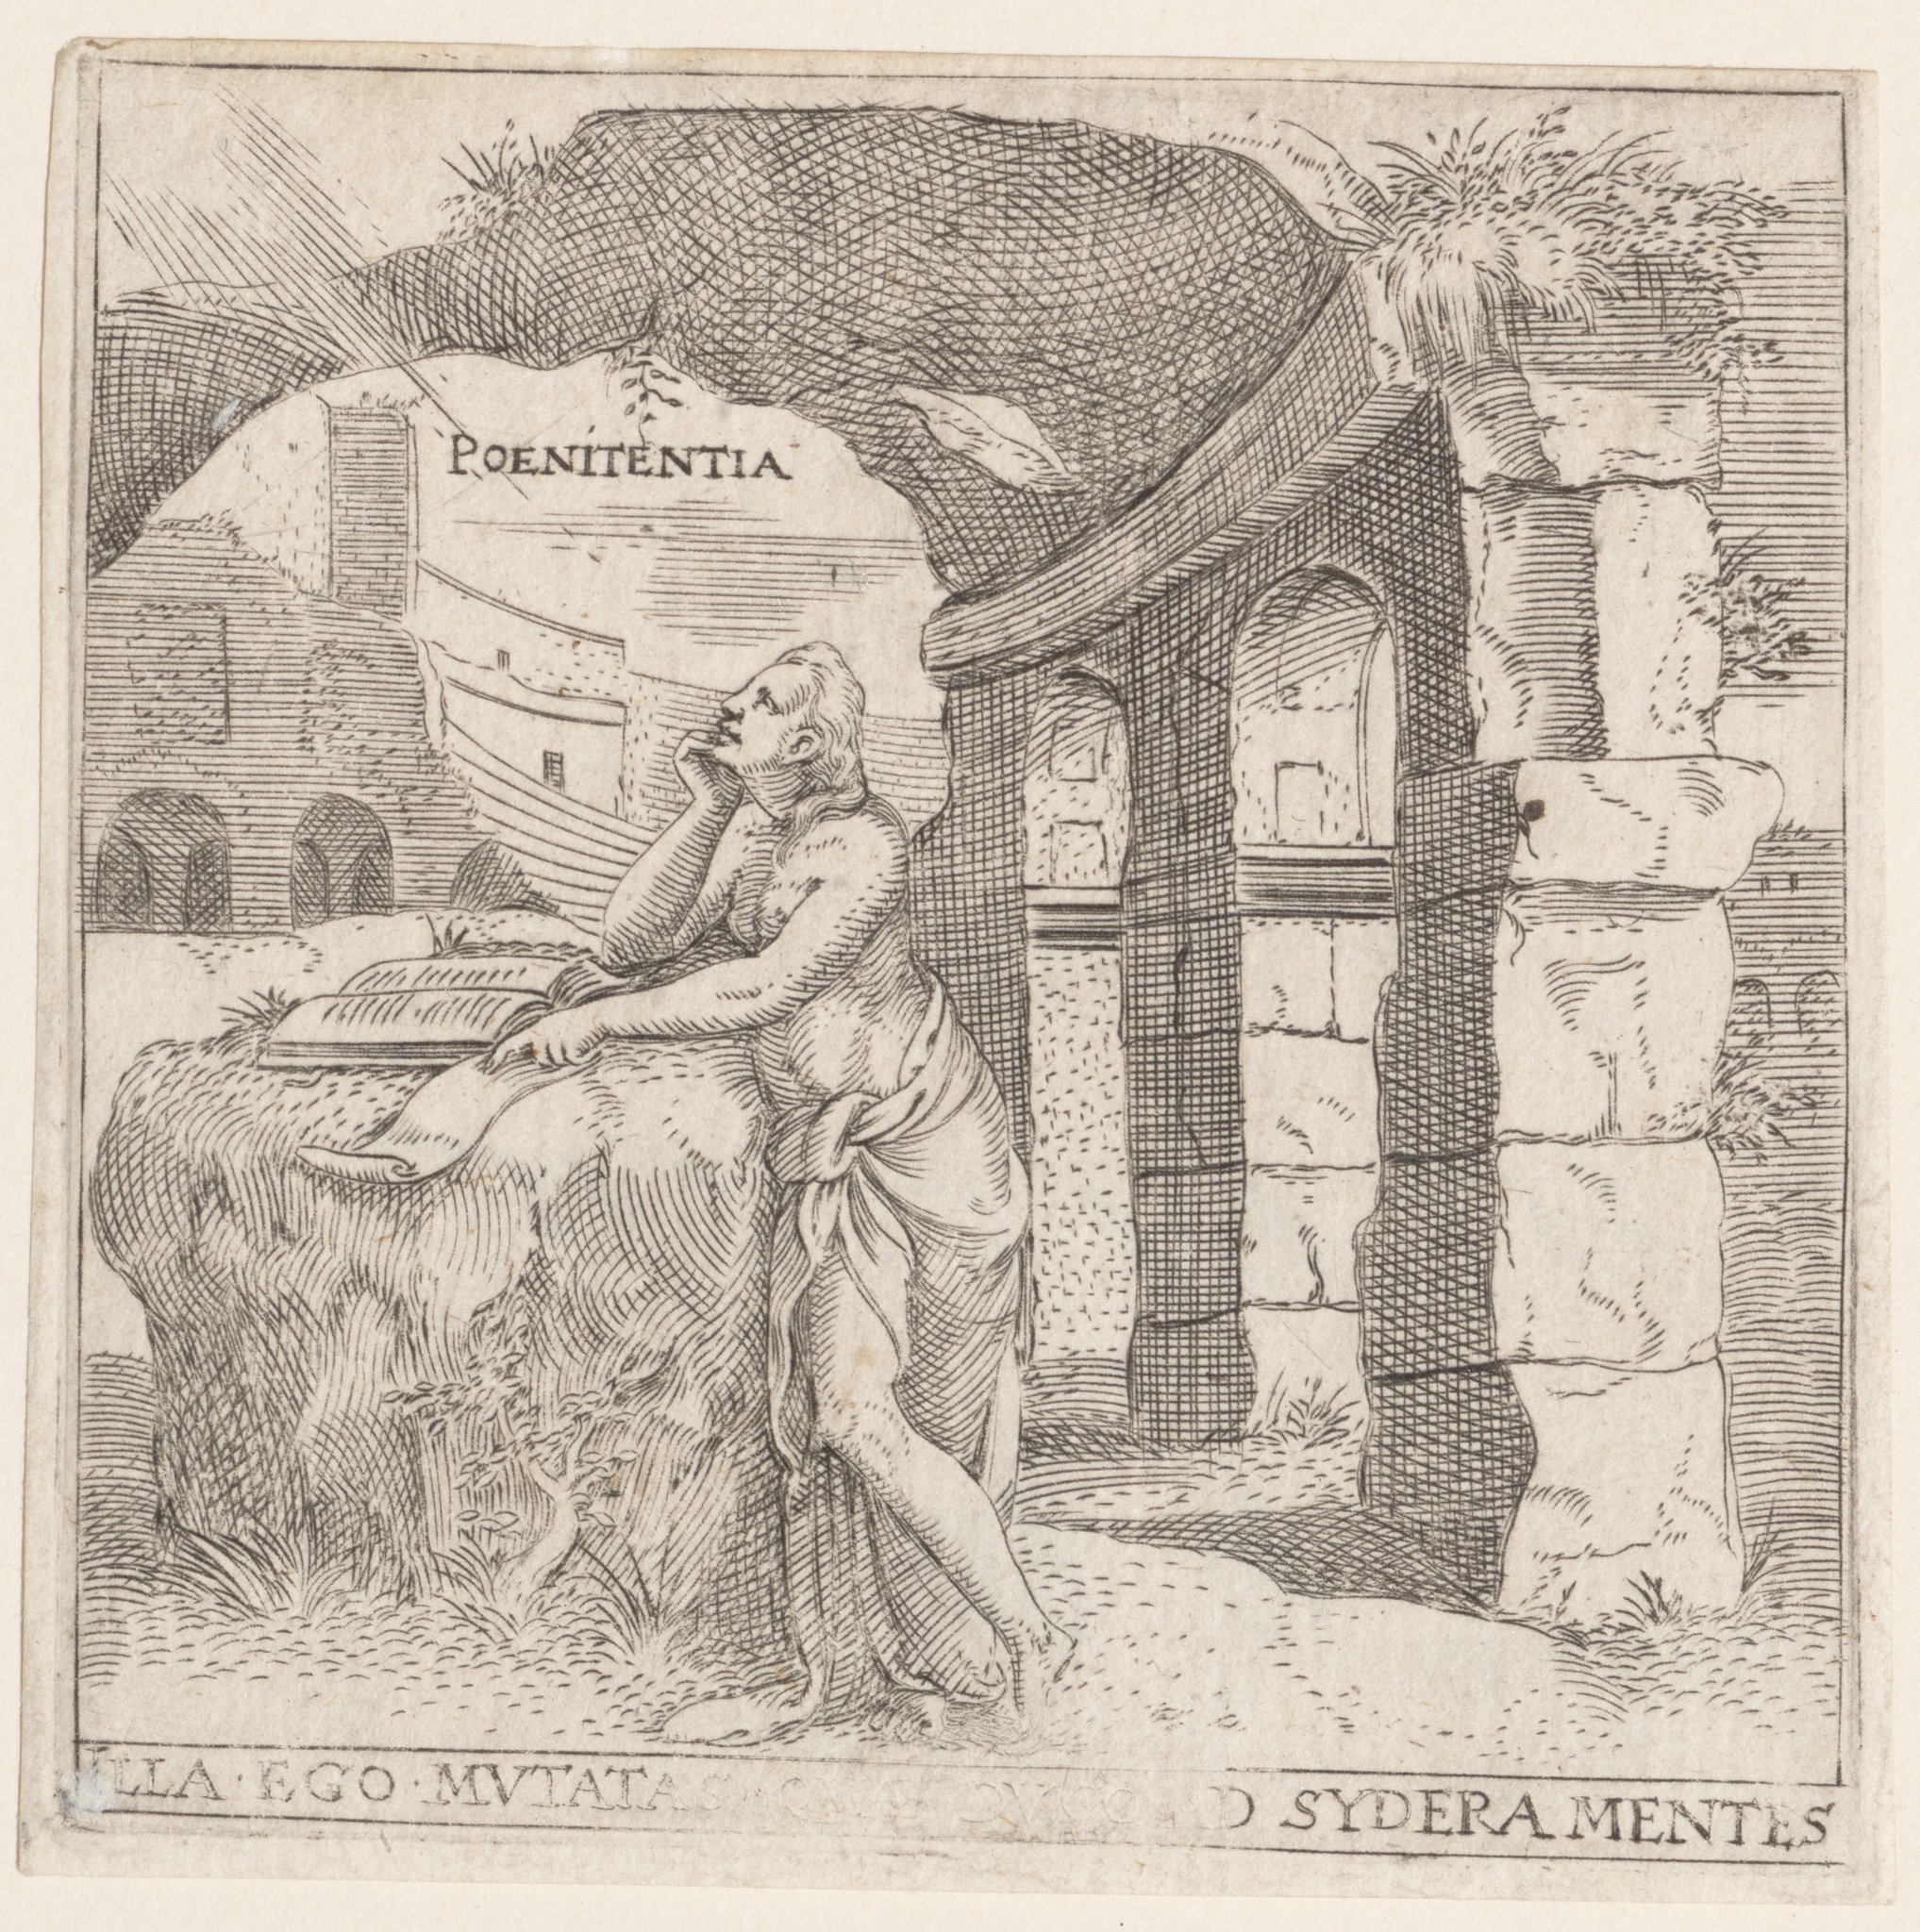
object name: print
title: Penitence (Poenitentia)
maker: enea vico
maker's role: artist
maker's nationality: italian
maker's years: 1523-1567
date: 1545-1550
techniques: engraving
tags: contemplation,women